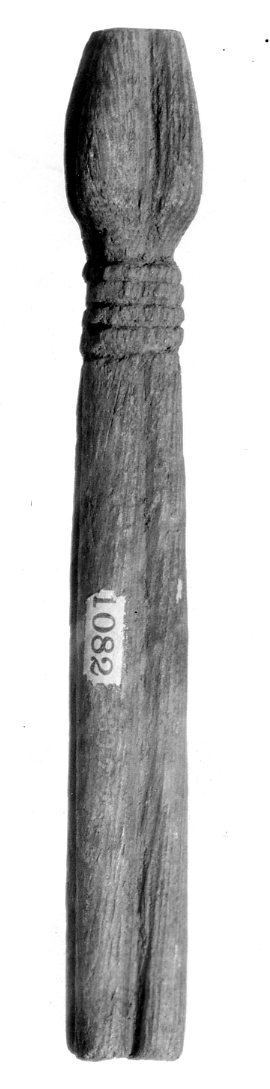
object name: furniture part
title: Furniture element in the form of a column with lotus bud capital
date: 1981-1550 BCE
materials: wood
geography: egypt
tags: furniture